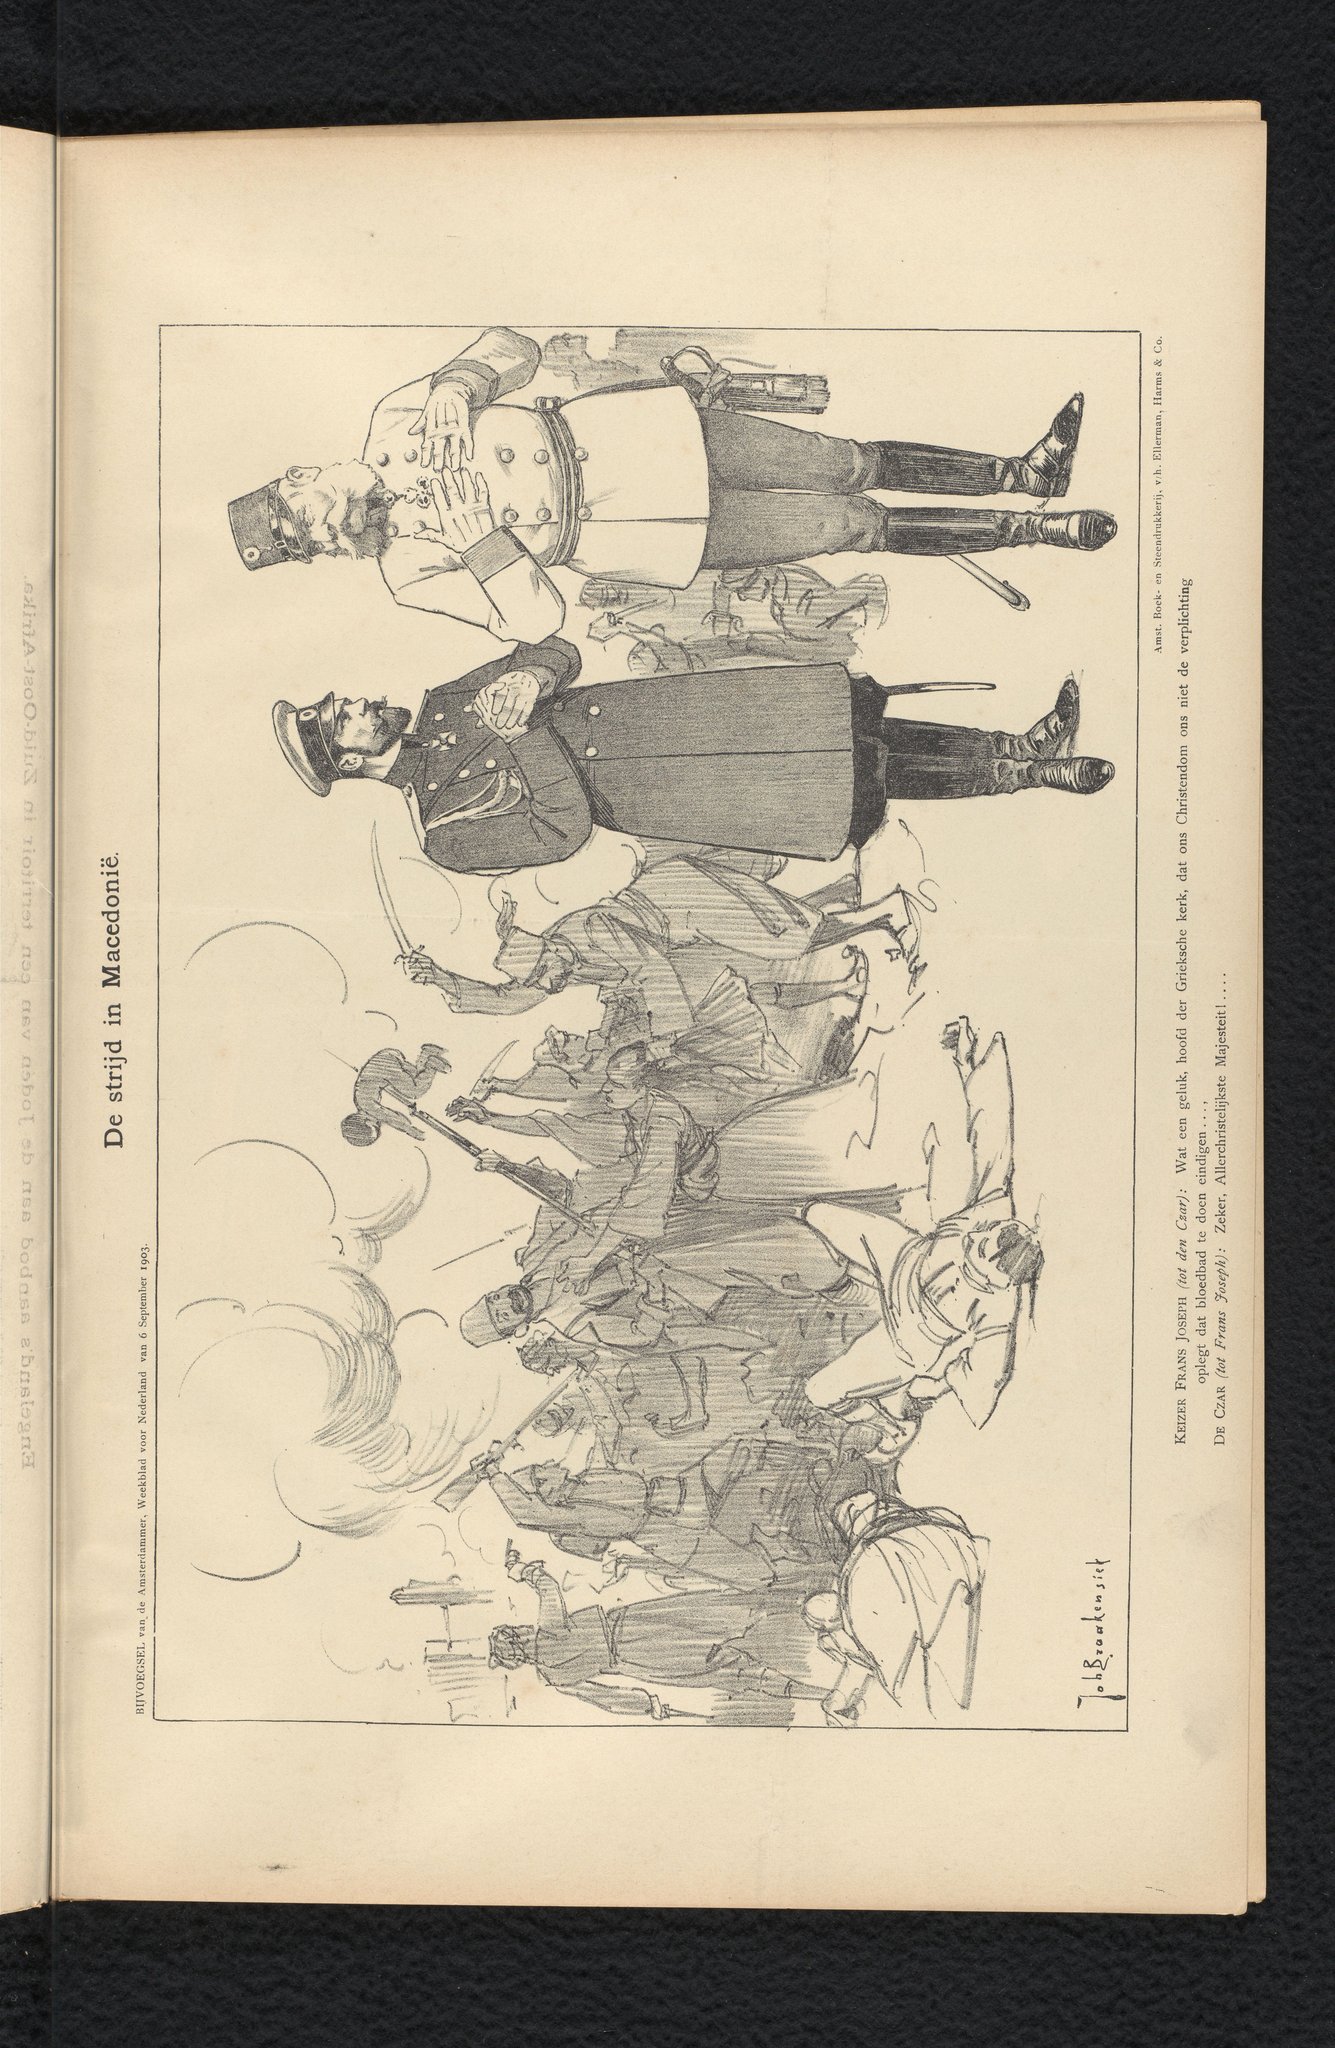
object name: cartoon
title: De strijd in Macedonië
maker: johan braakensiek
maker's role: draughtsman, print maker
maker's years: 1858-1940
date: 1903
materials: paper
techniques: lithograph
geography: netherlands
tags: vienna, massacre ~ war, political caricatures and satires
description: De Oostenrijkse keizer Frans Jozef I en de Russische tsaar Nicolaas II staan met de rug naar een bloedig tafereel van oorlog en moord gepleegd door de Ottomanen in het Griekse Macedonië. Als christelijke vorsten vinden ze dat zij niet hoeven in te grijpen in een conflict tussen niet-christelijke volkeren.